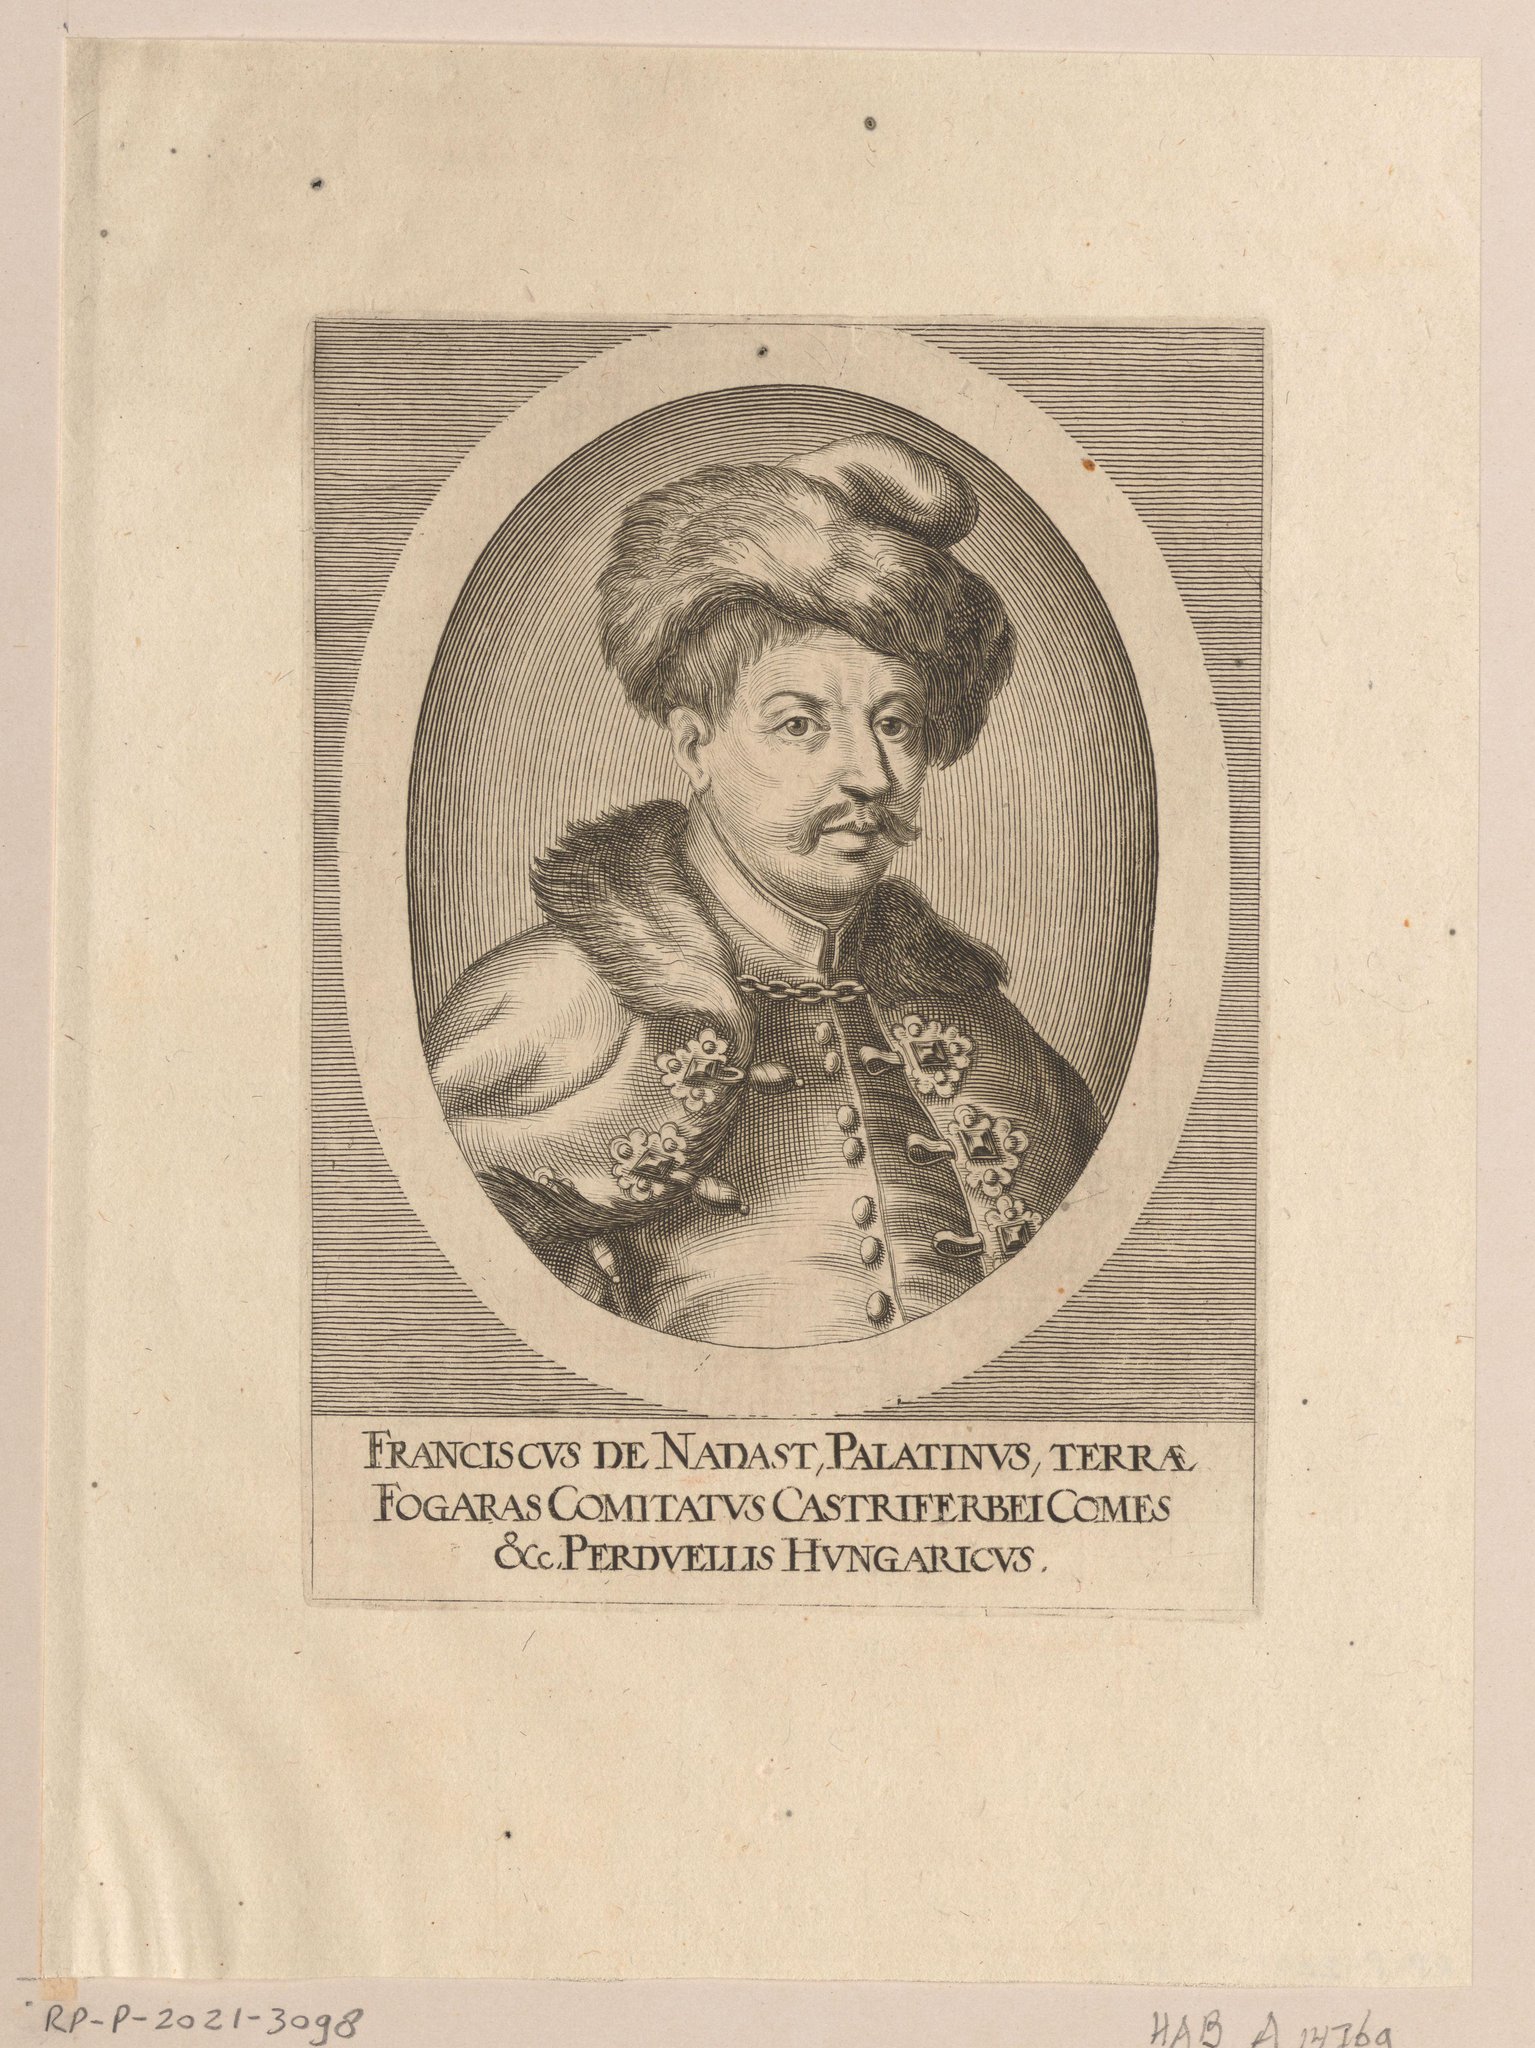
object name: print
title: Portret van Ferenc Nádasdy III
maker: Anonymous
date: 1677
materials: paper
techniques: engraving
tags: vienna, historical persons, law and jurisprudence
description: Prent mogelijk uit: Theatrum Europaeum. Frankfurt am Main: Matthäus Merian II, Caspar Merian en erven Thomas Matthias Götz, dl. 10, 1677.